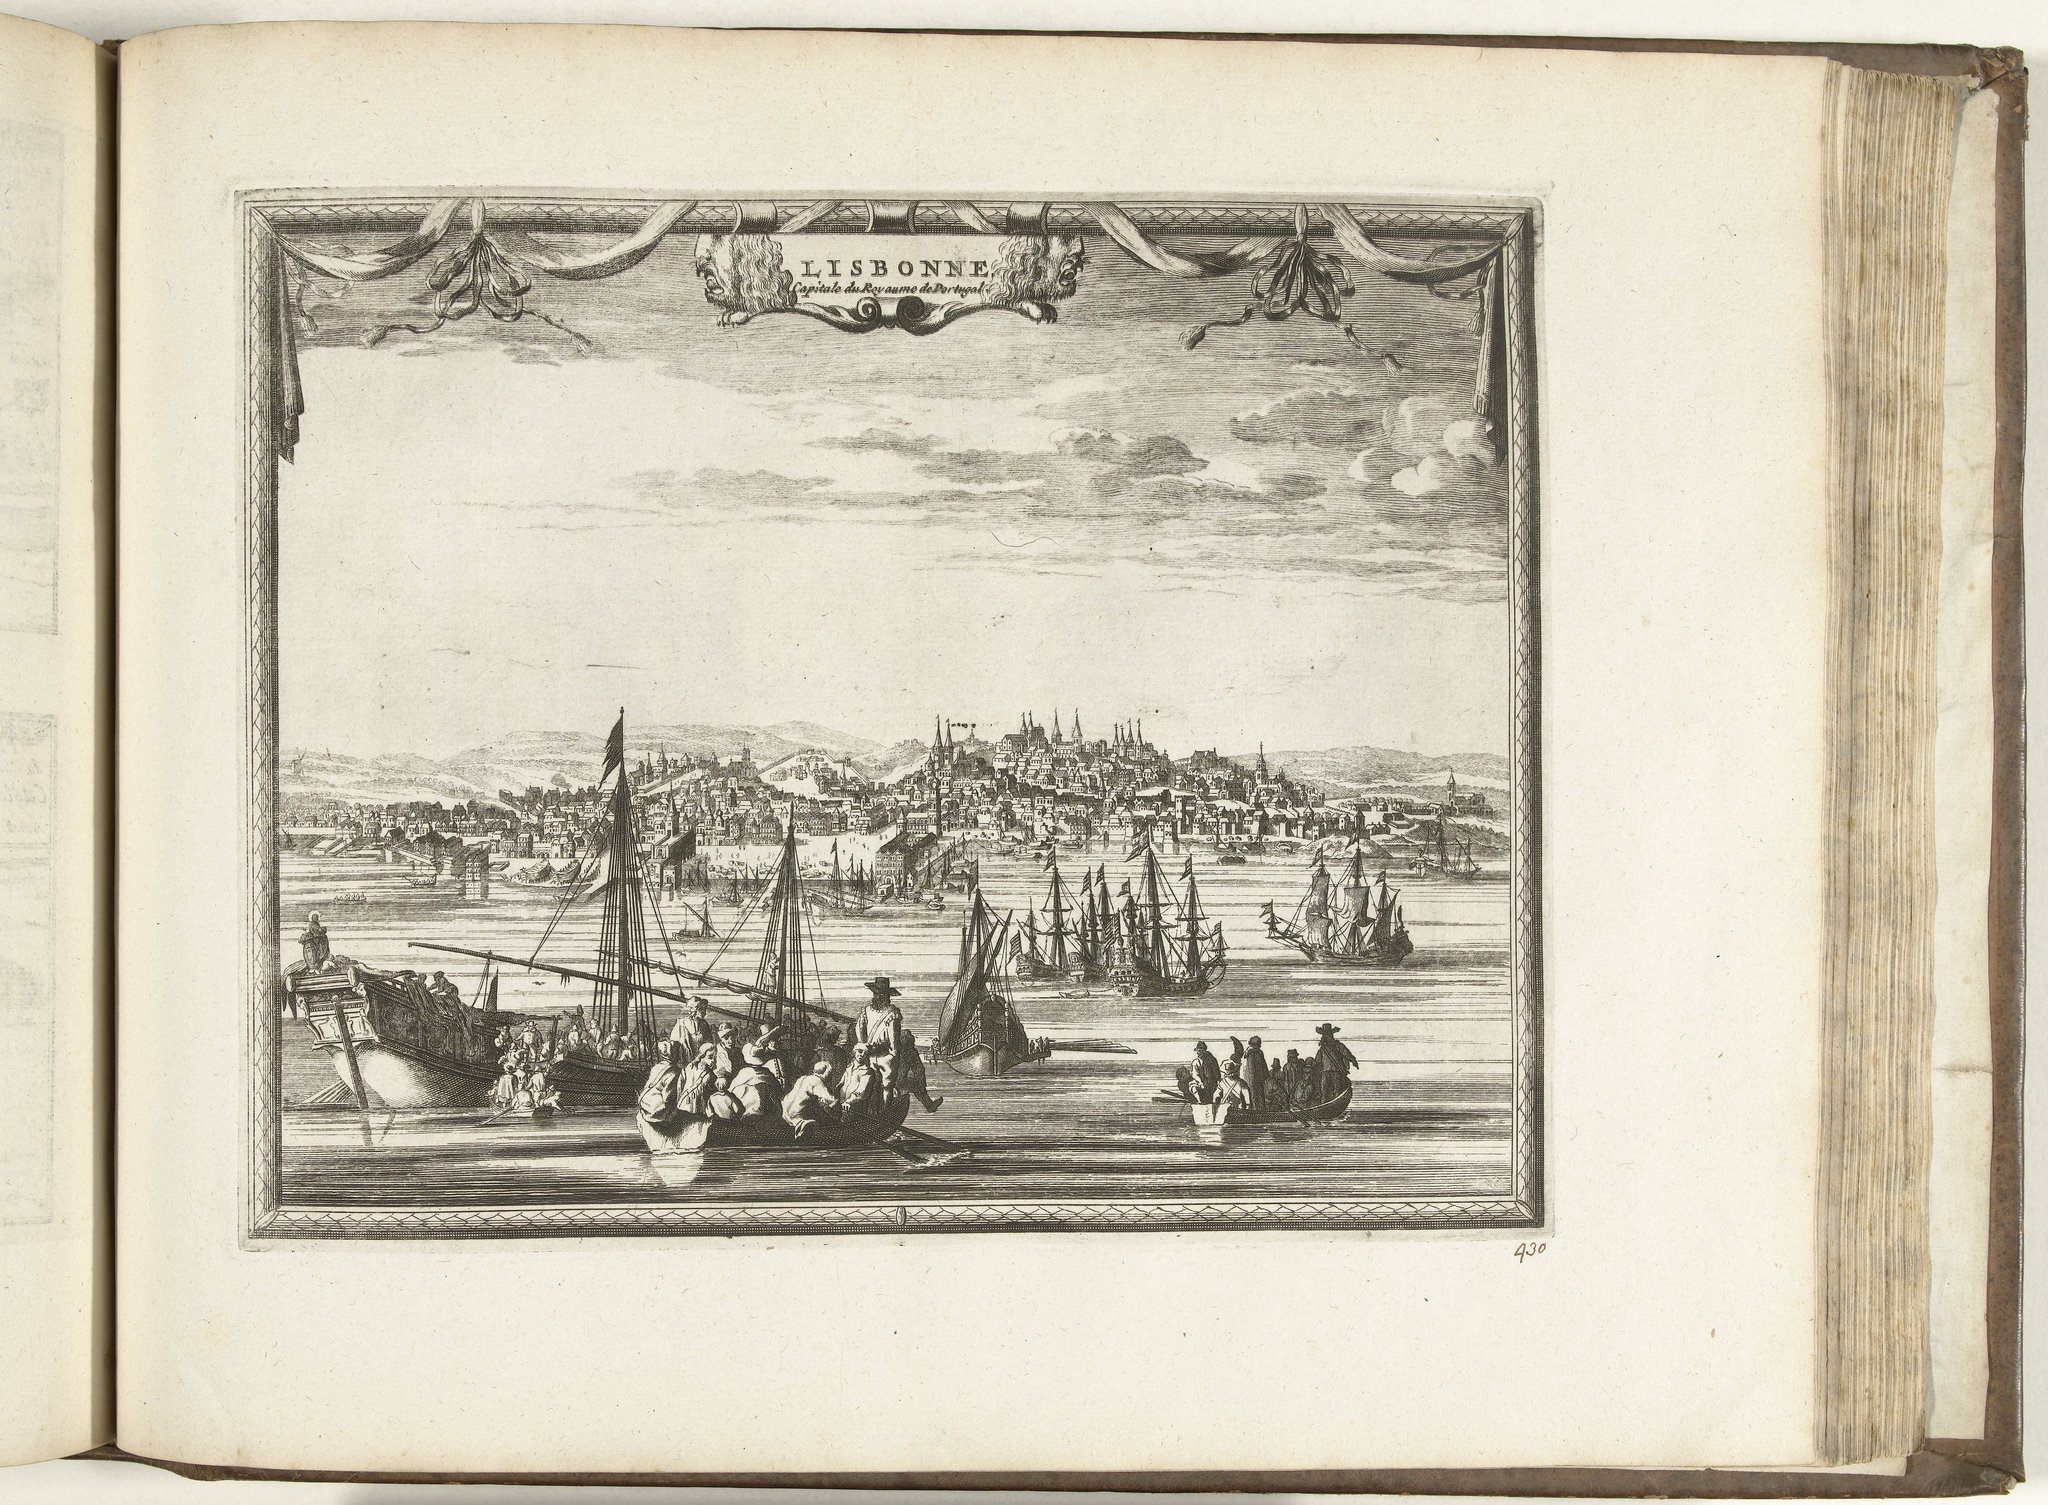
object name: print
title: Gezicht op Lissabon, 1726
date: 1726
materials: paper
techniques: etching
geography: northern netherlands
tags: lissabon, spaanse successieoorlog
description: Gezicht op Lissabon, op de voorgrond sloepen met mensen op het water. Plaat nr. 430 in deel XVII van het prentwerk: Les Forces de l'Europe, Asie, Afrique et Amerique ... Comme aussi les Cartes des Côtes de France et d'Espagne uit 1726, dit tweede deel met 271 met de hand genummerde platen van vermaarde sterke steden en vestingen in het kader van de Spaanse Successieoorlog 1701-1713. Voor het merendeel zijn deze platen gekopieerd naar de anonieme Franse platen van vermaarde sterke steden en vestingen: in Les forces de l'Europe en in: Le theatre de la guerre, dans les Pays-Bas, beide oorspronkelijk uitgegeven door Nicolas de Fer te Parijs (1693-1697) in het kader van de Negenjarige Oorlog. Titel in het Frans.